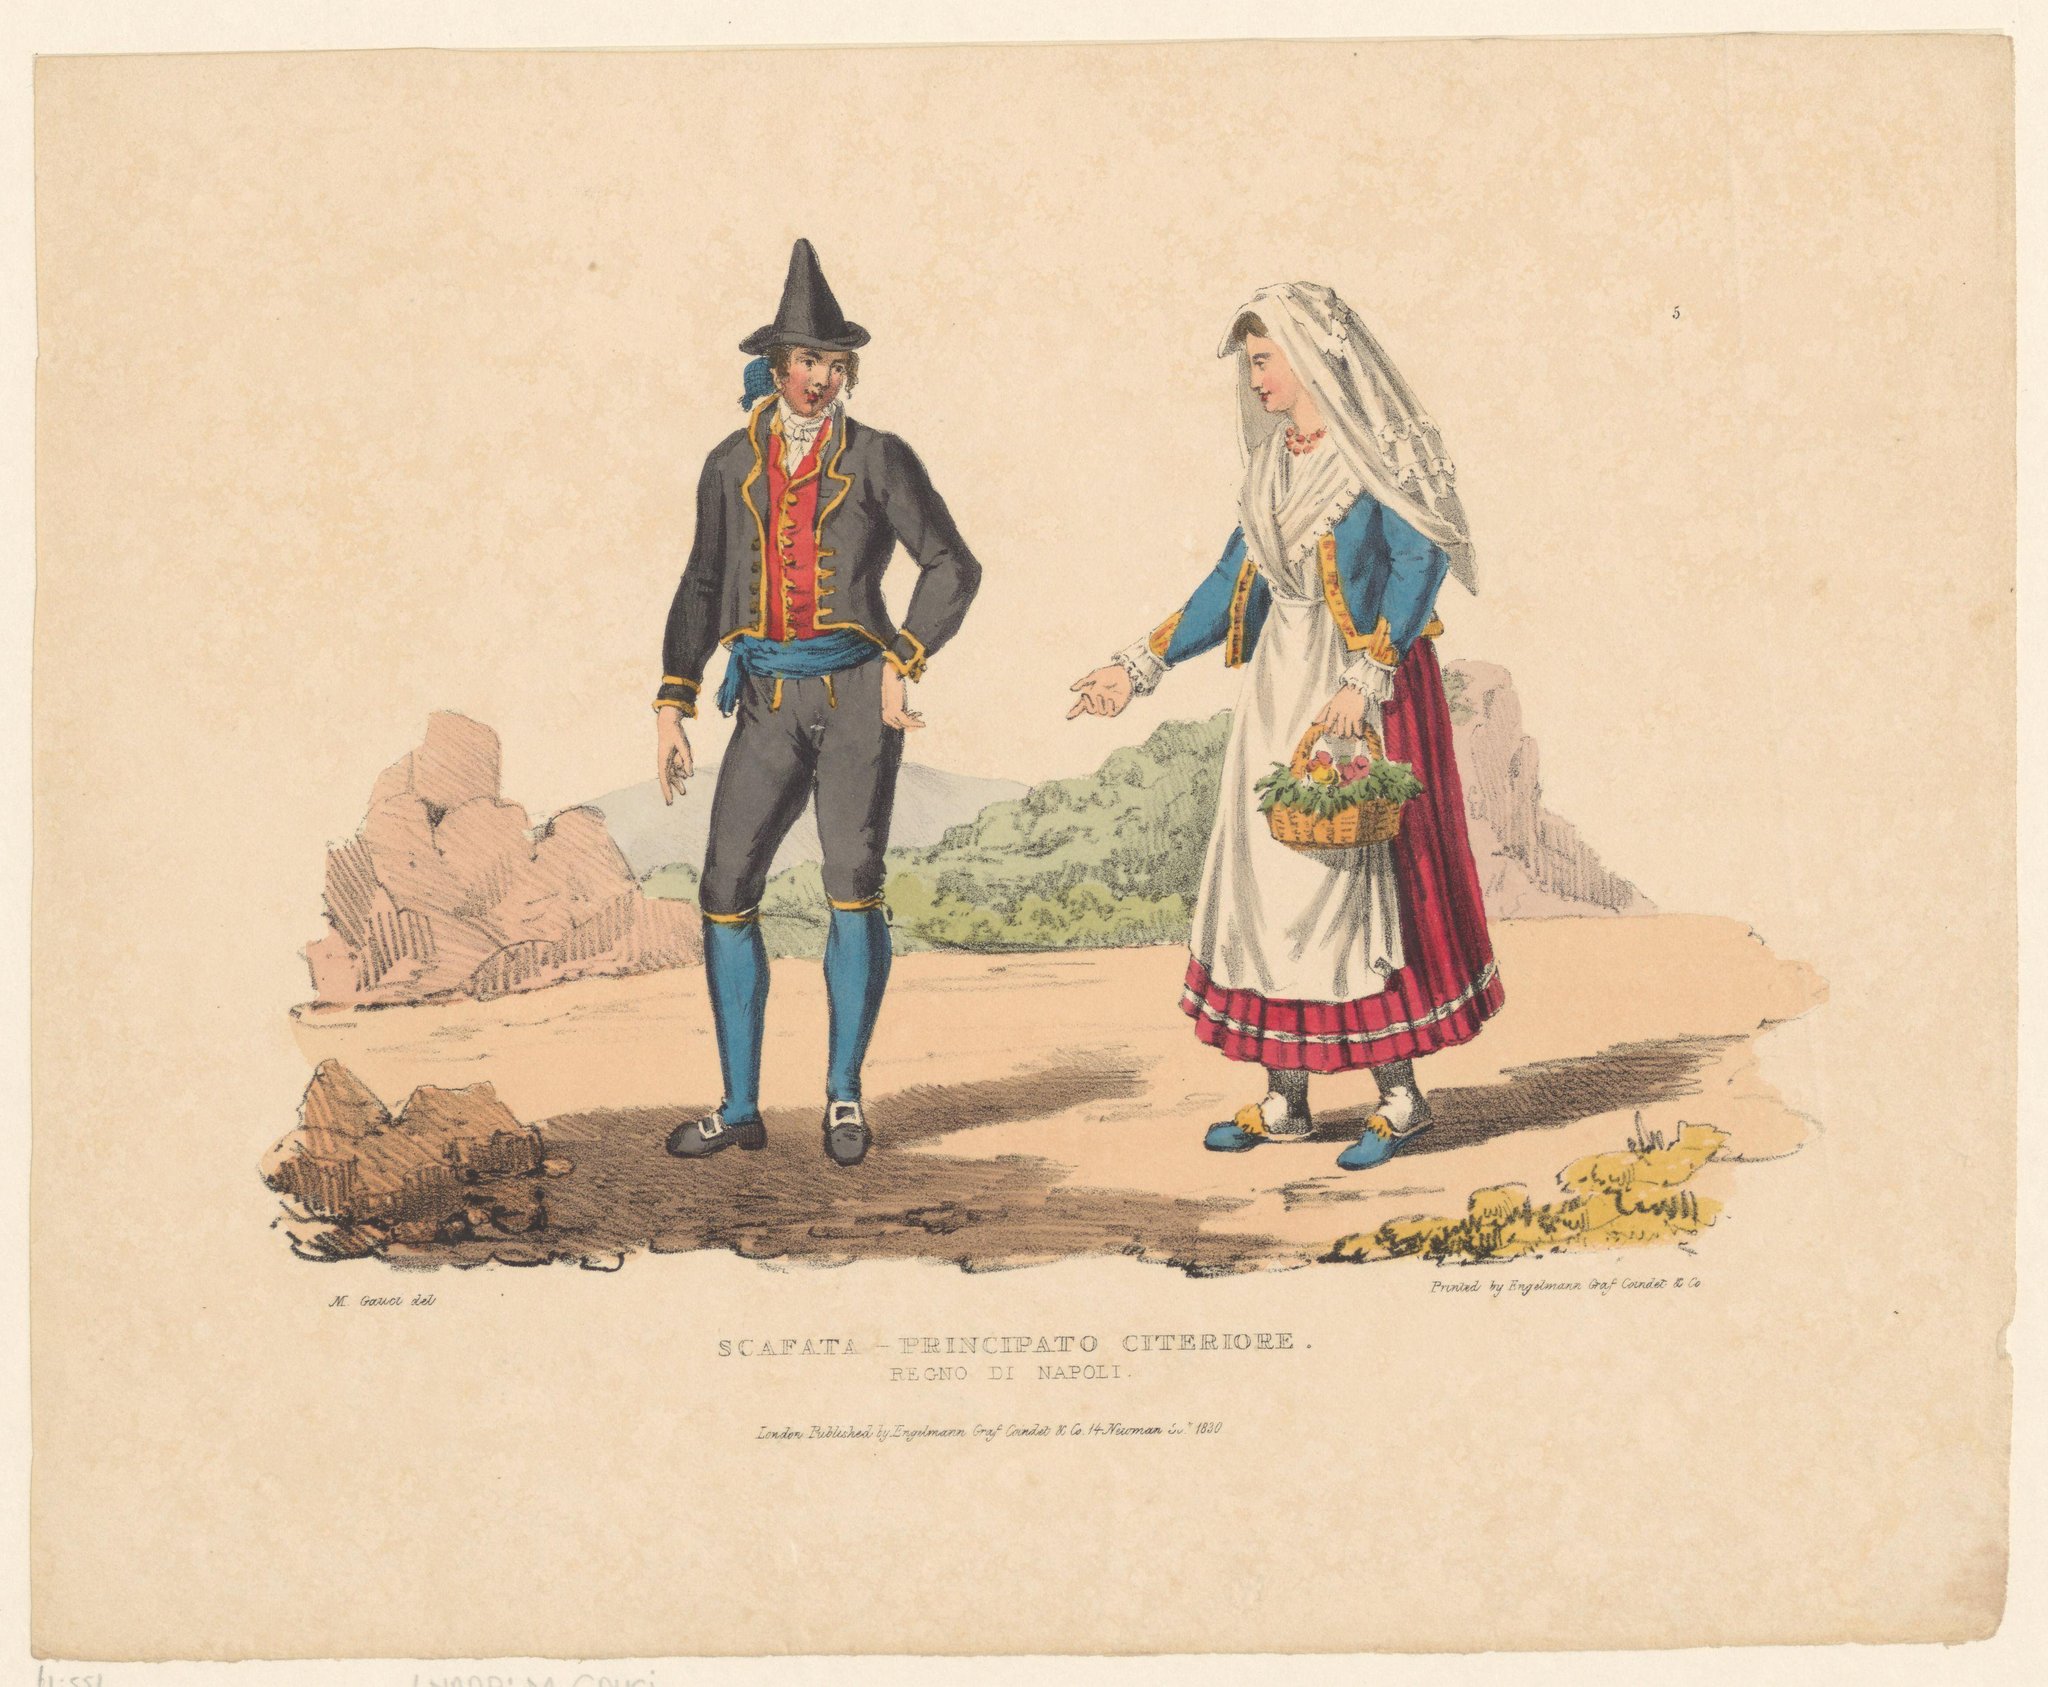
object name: print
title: Man en vrouw in klederdracht uit Scafati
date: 1830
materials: paper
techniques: hand coloring, lithograph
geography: london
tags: adult woman, adult man, folk costume, regional costume, europeans (with name)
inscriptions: collector's mark: Lugt 2228, mark: ‘School voor de grafische vakken te Utrecht’